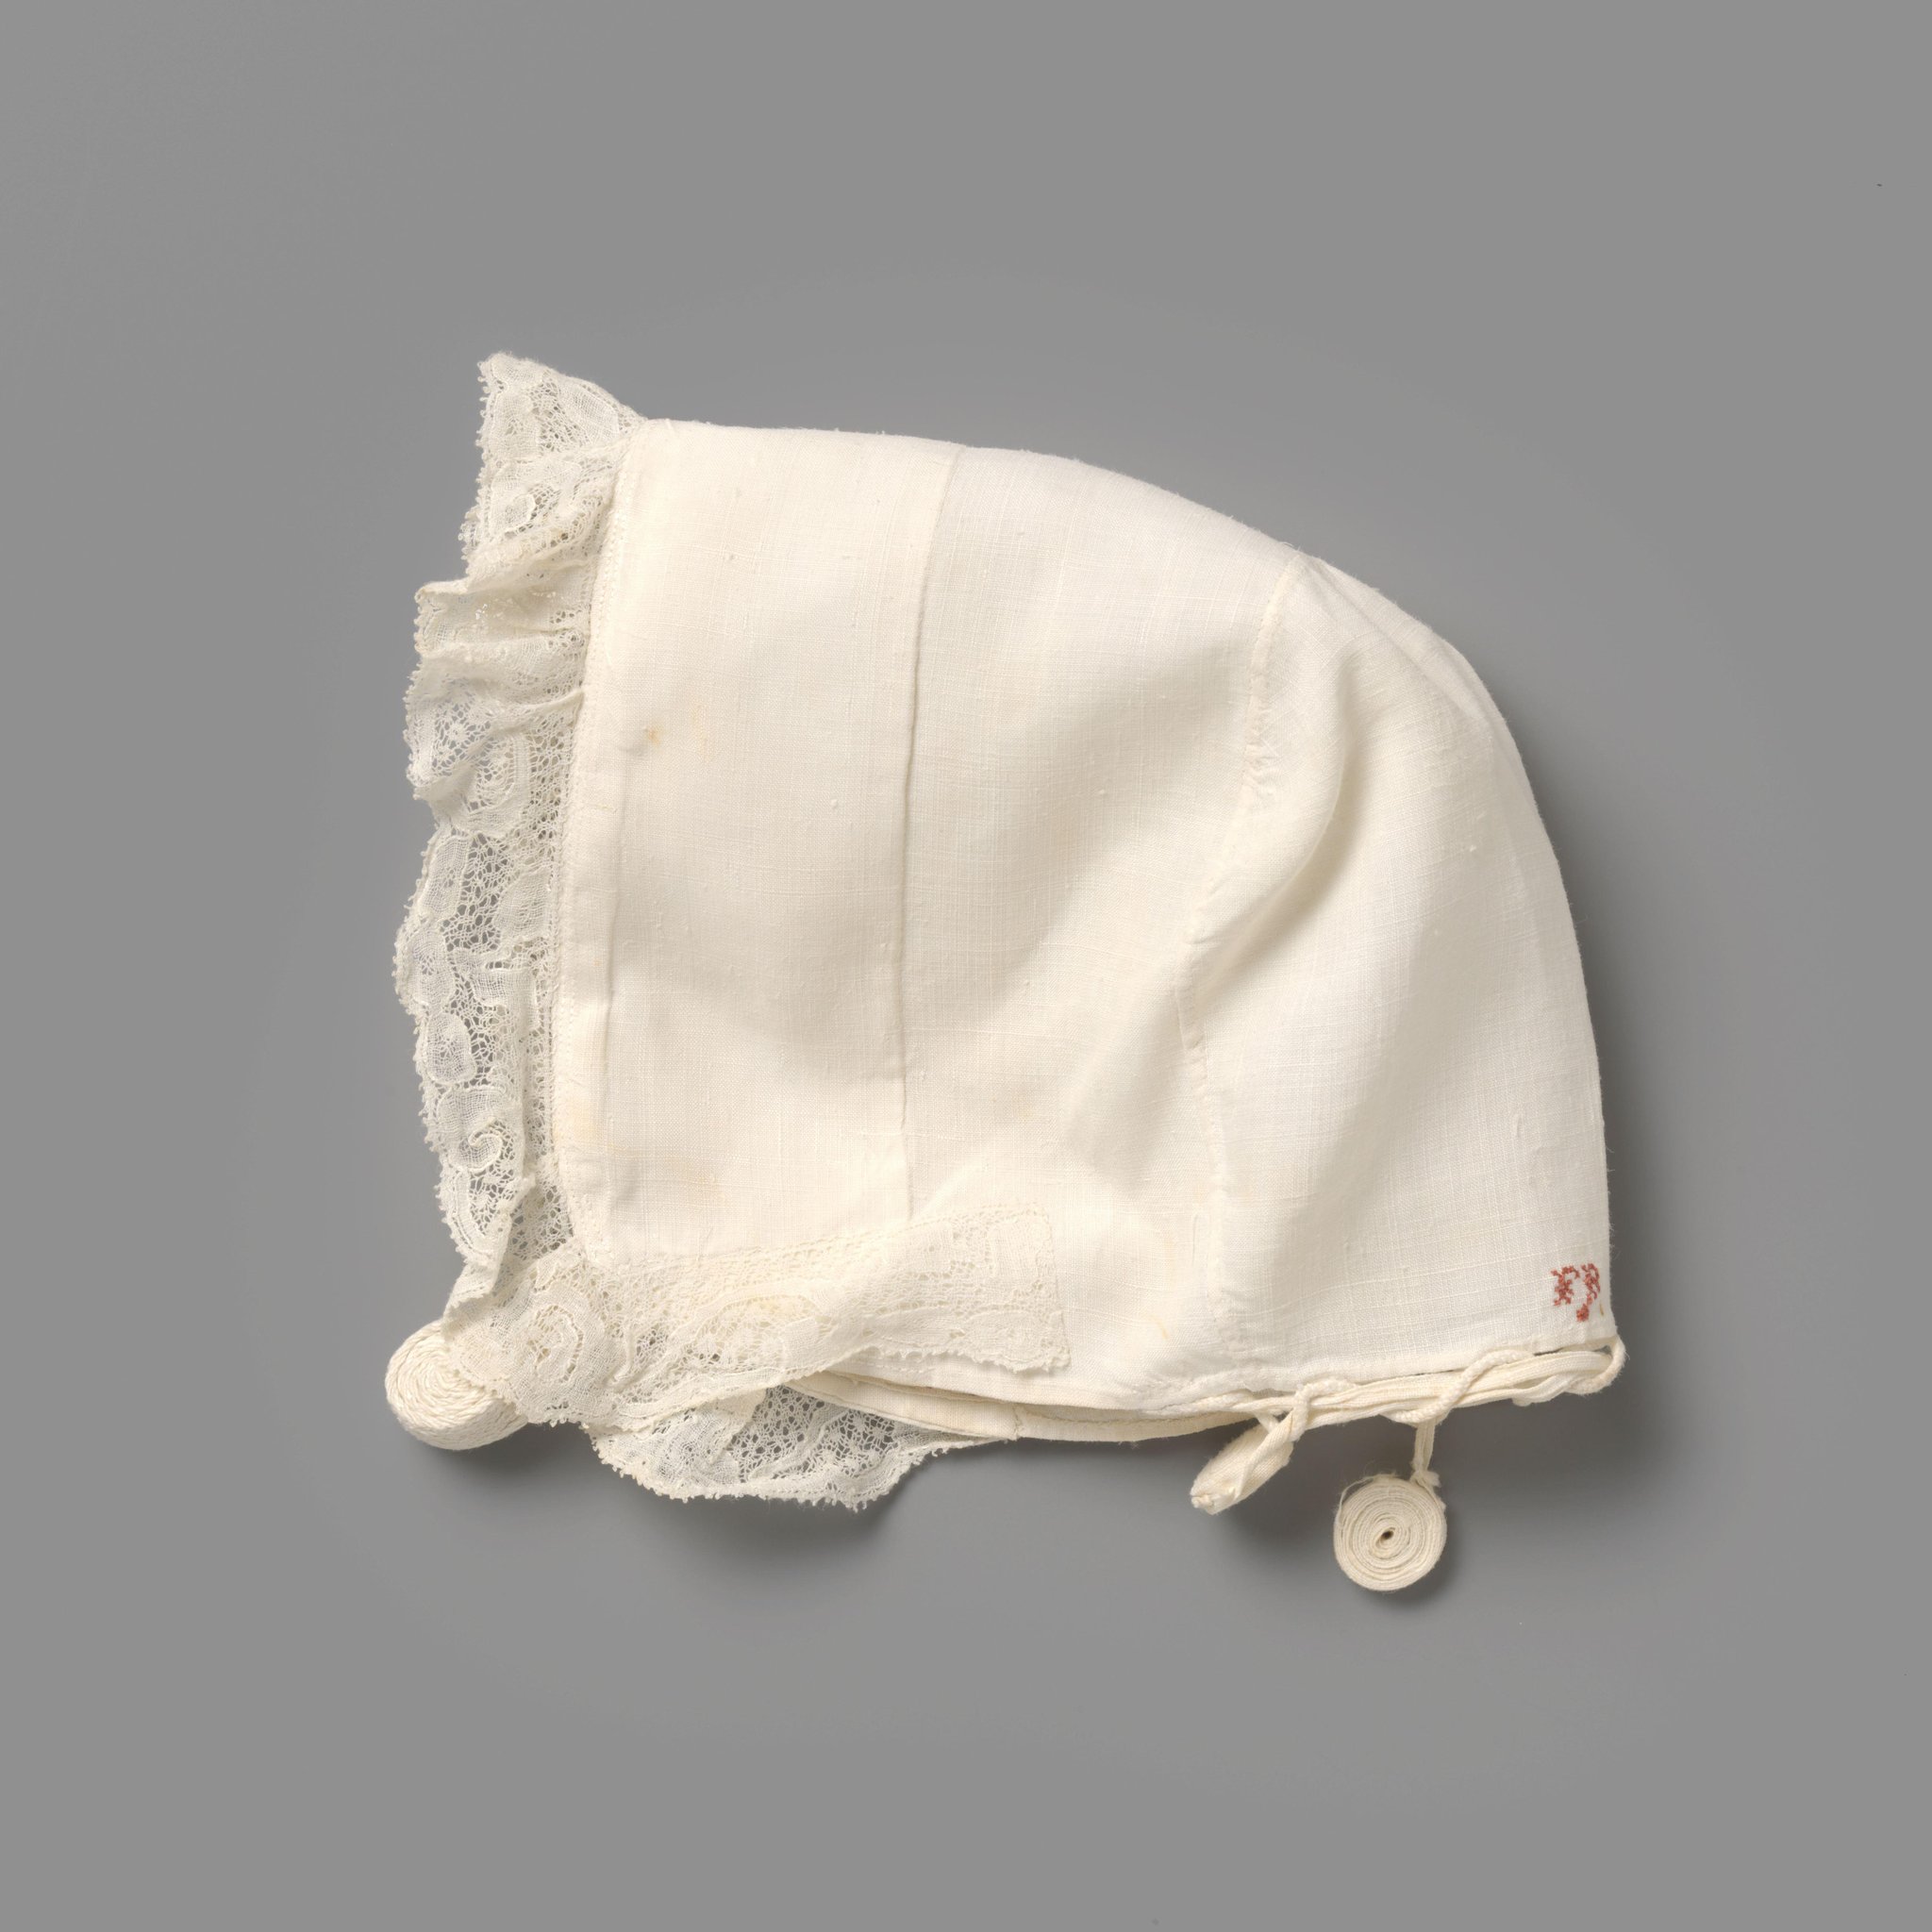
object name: cap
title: Kindermuts van linnen met kanten stroken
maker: Anonymous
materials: linen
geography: europe